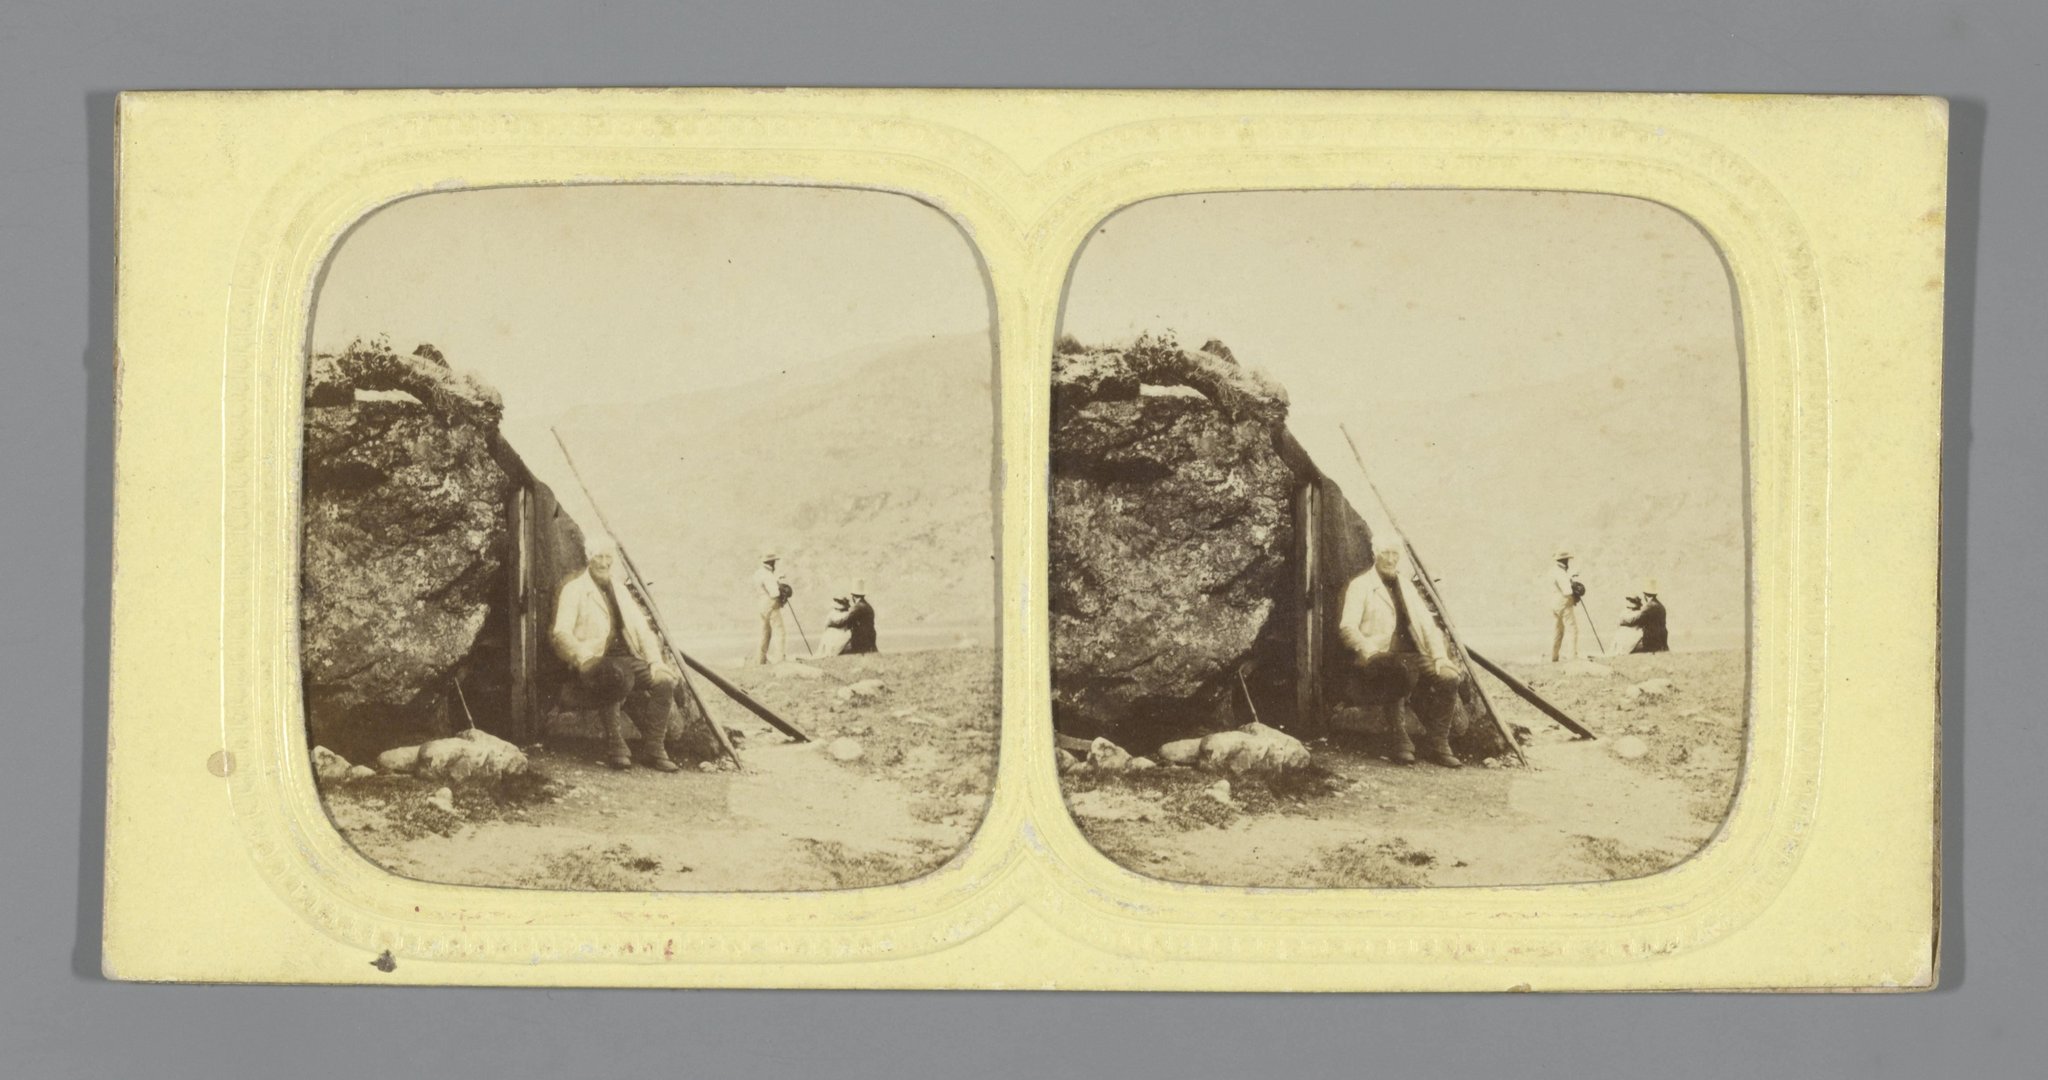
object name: tissue stereograph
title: Man bij rots, op achtergrond drie mensen aan een meer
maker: Anonymous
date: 1855-1875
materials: cardboard, paper, photographic support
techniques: albumen print, hand coloring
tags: lake, rock-formations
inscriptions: number: ‘75’